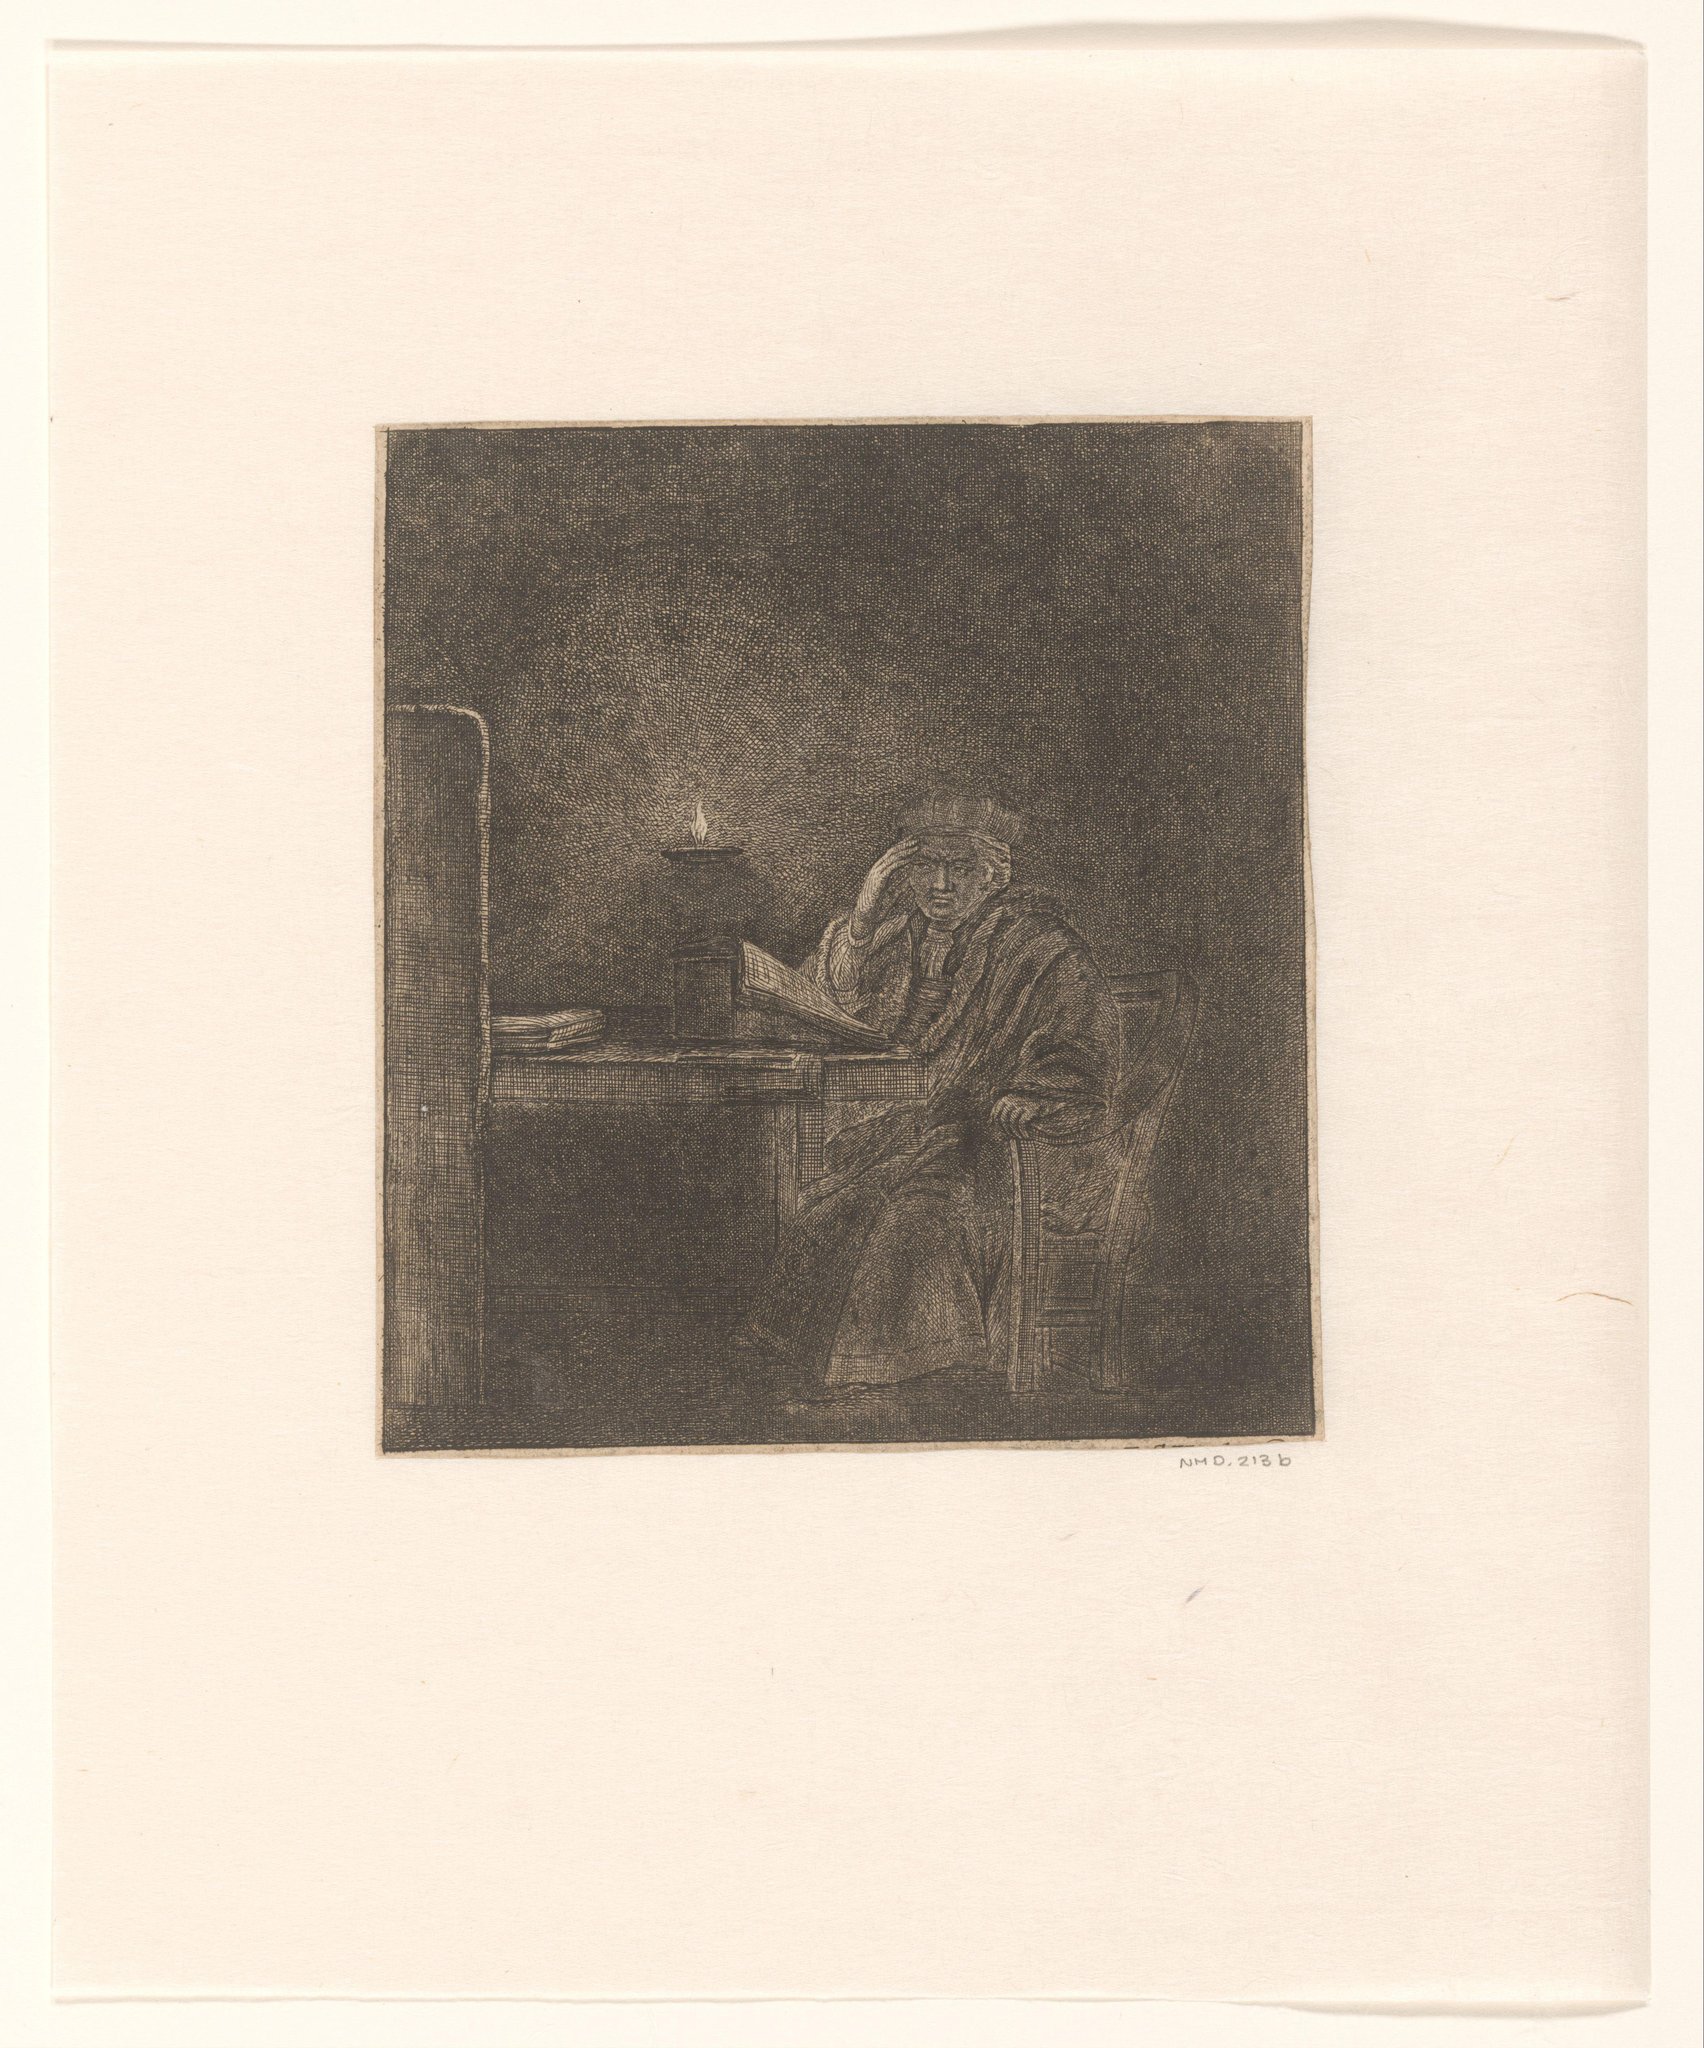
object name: print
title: Student at a table by candlelight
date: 1711-1800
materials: paper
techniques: etching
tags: studying at night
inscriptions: collector's mark: Lugt 2760, collector's mark: Lugt 2228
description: Spiegelbeeldige kopie naar de gelijknamige prent van Rembrandt.